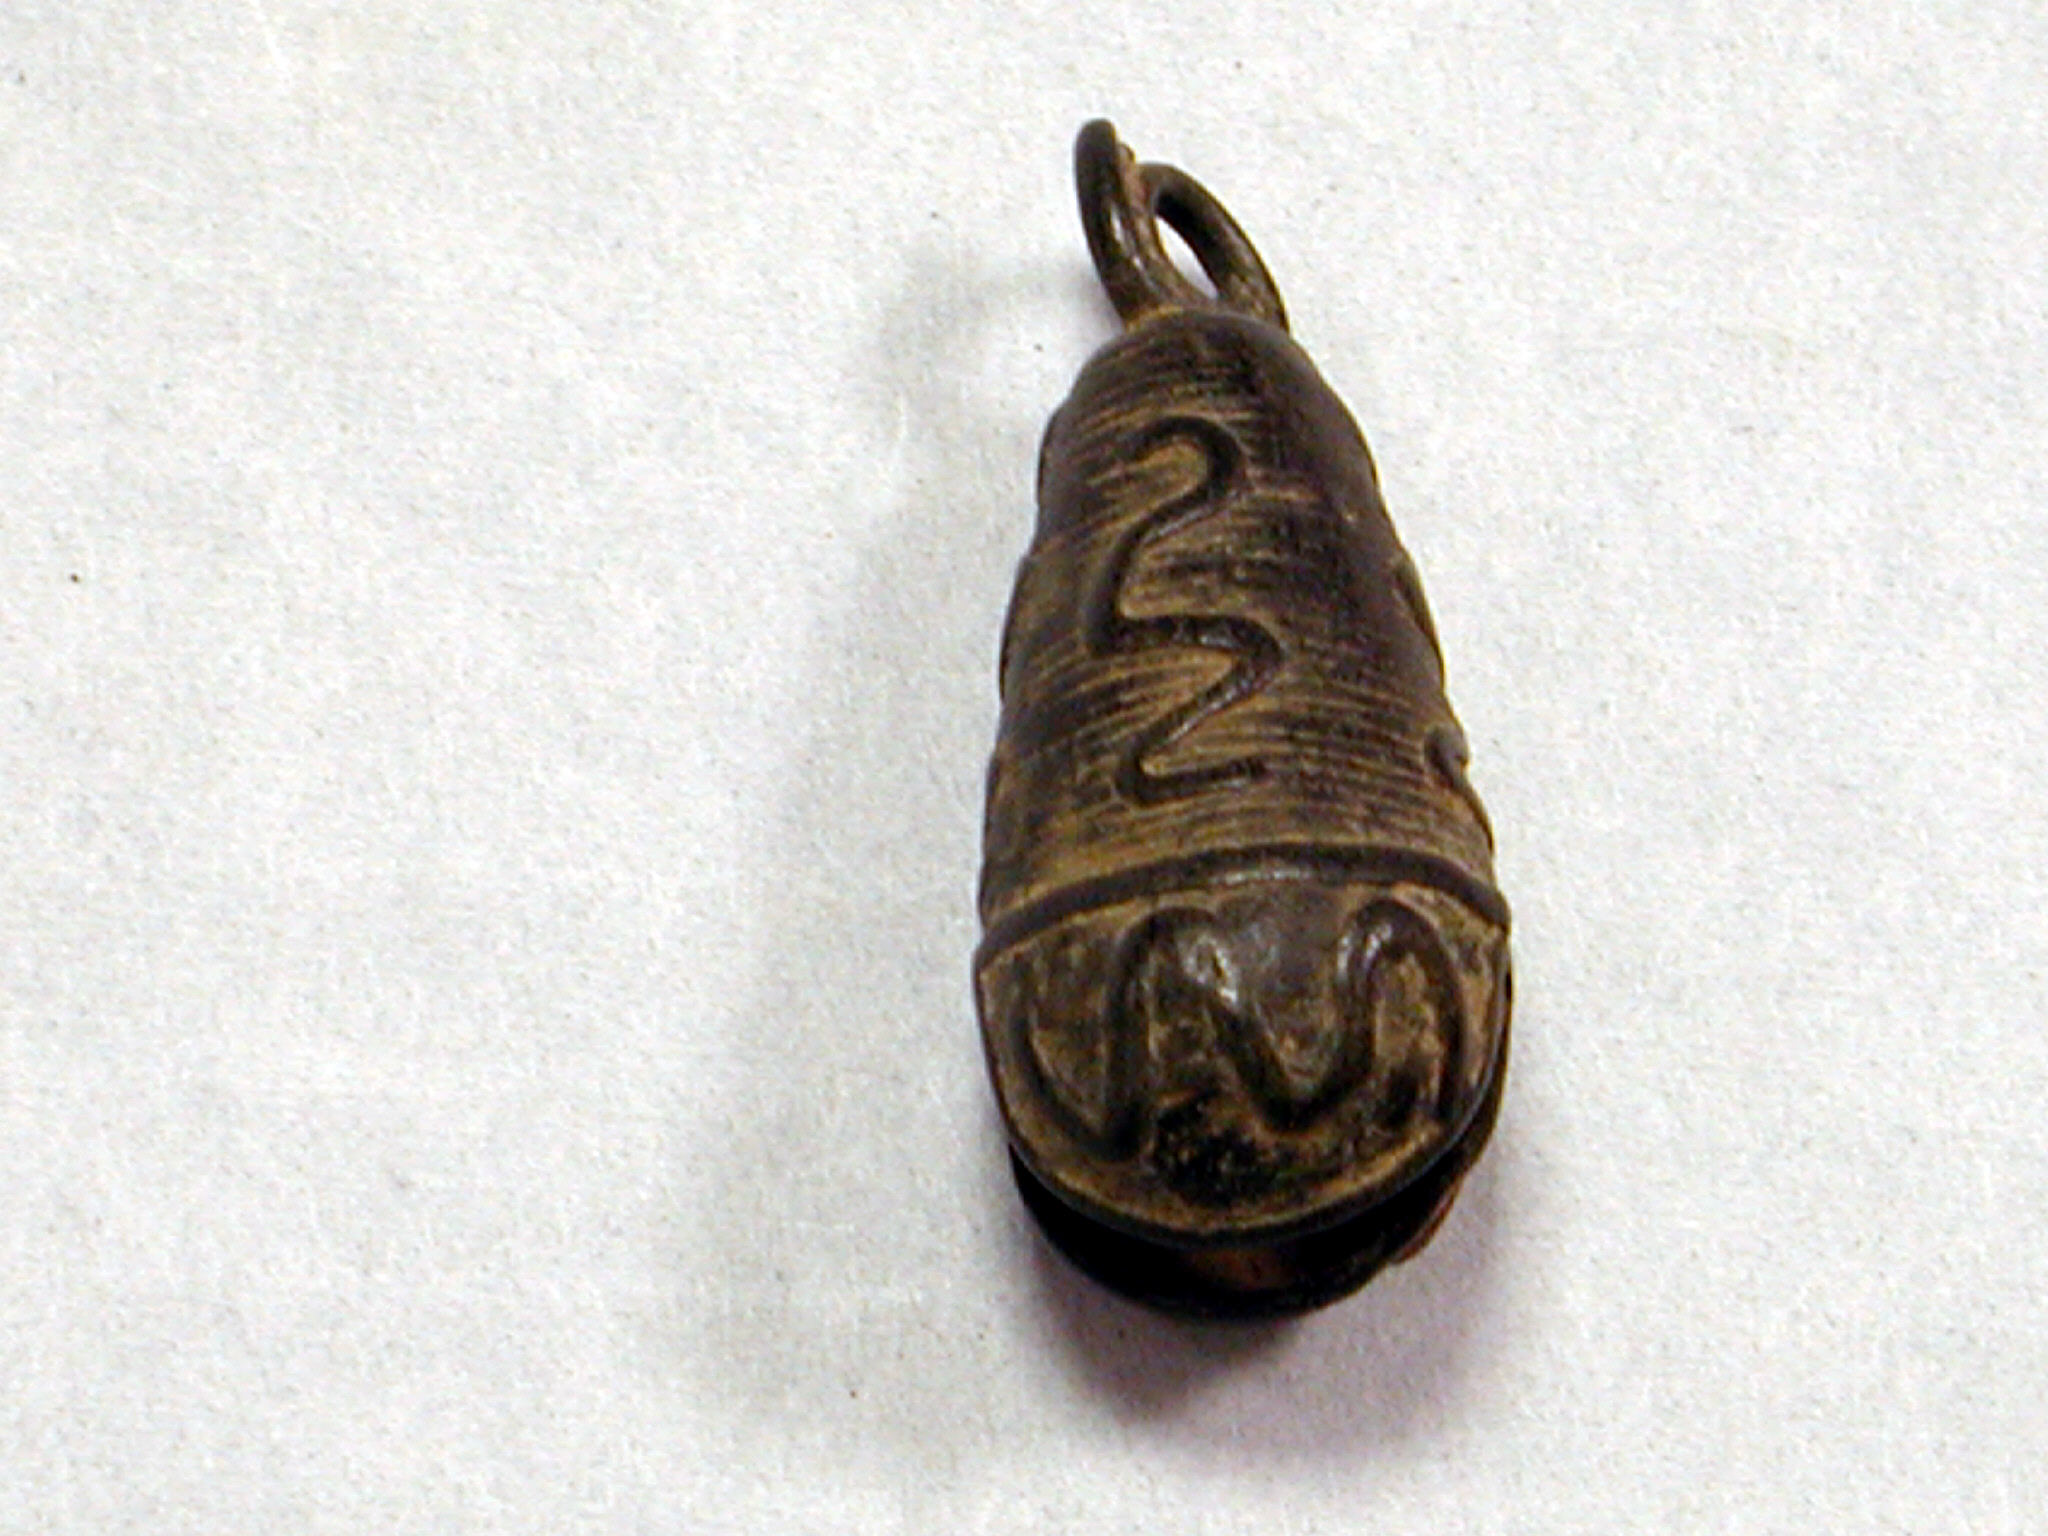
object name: bell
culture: valley of mexico or west mexico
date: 1001-1600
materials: copper, copper alloy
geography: mexico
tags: musical instruments,snakes